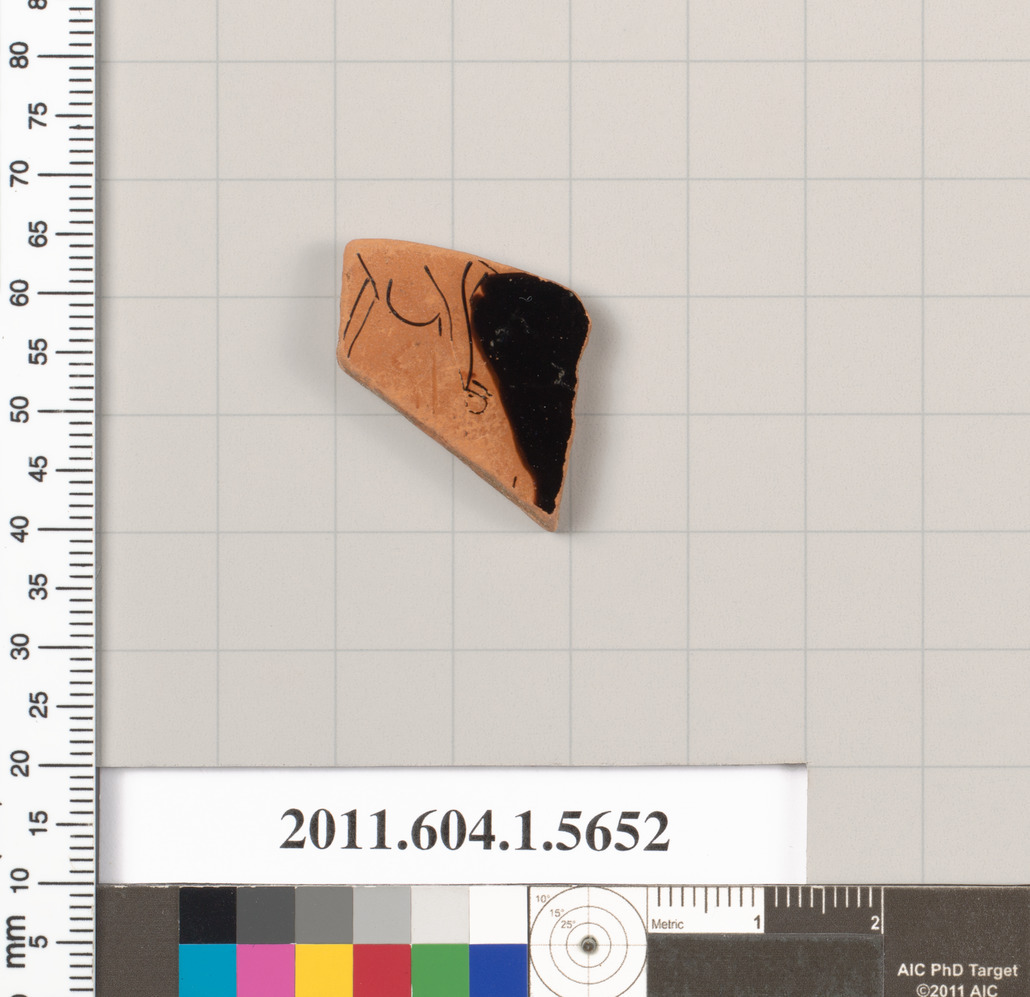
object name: kylix fragment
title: Terracotta fragment of a kylix (drinking cup)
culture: greek, attic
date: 475-451 BCE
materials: terracotta